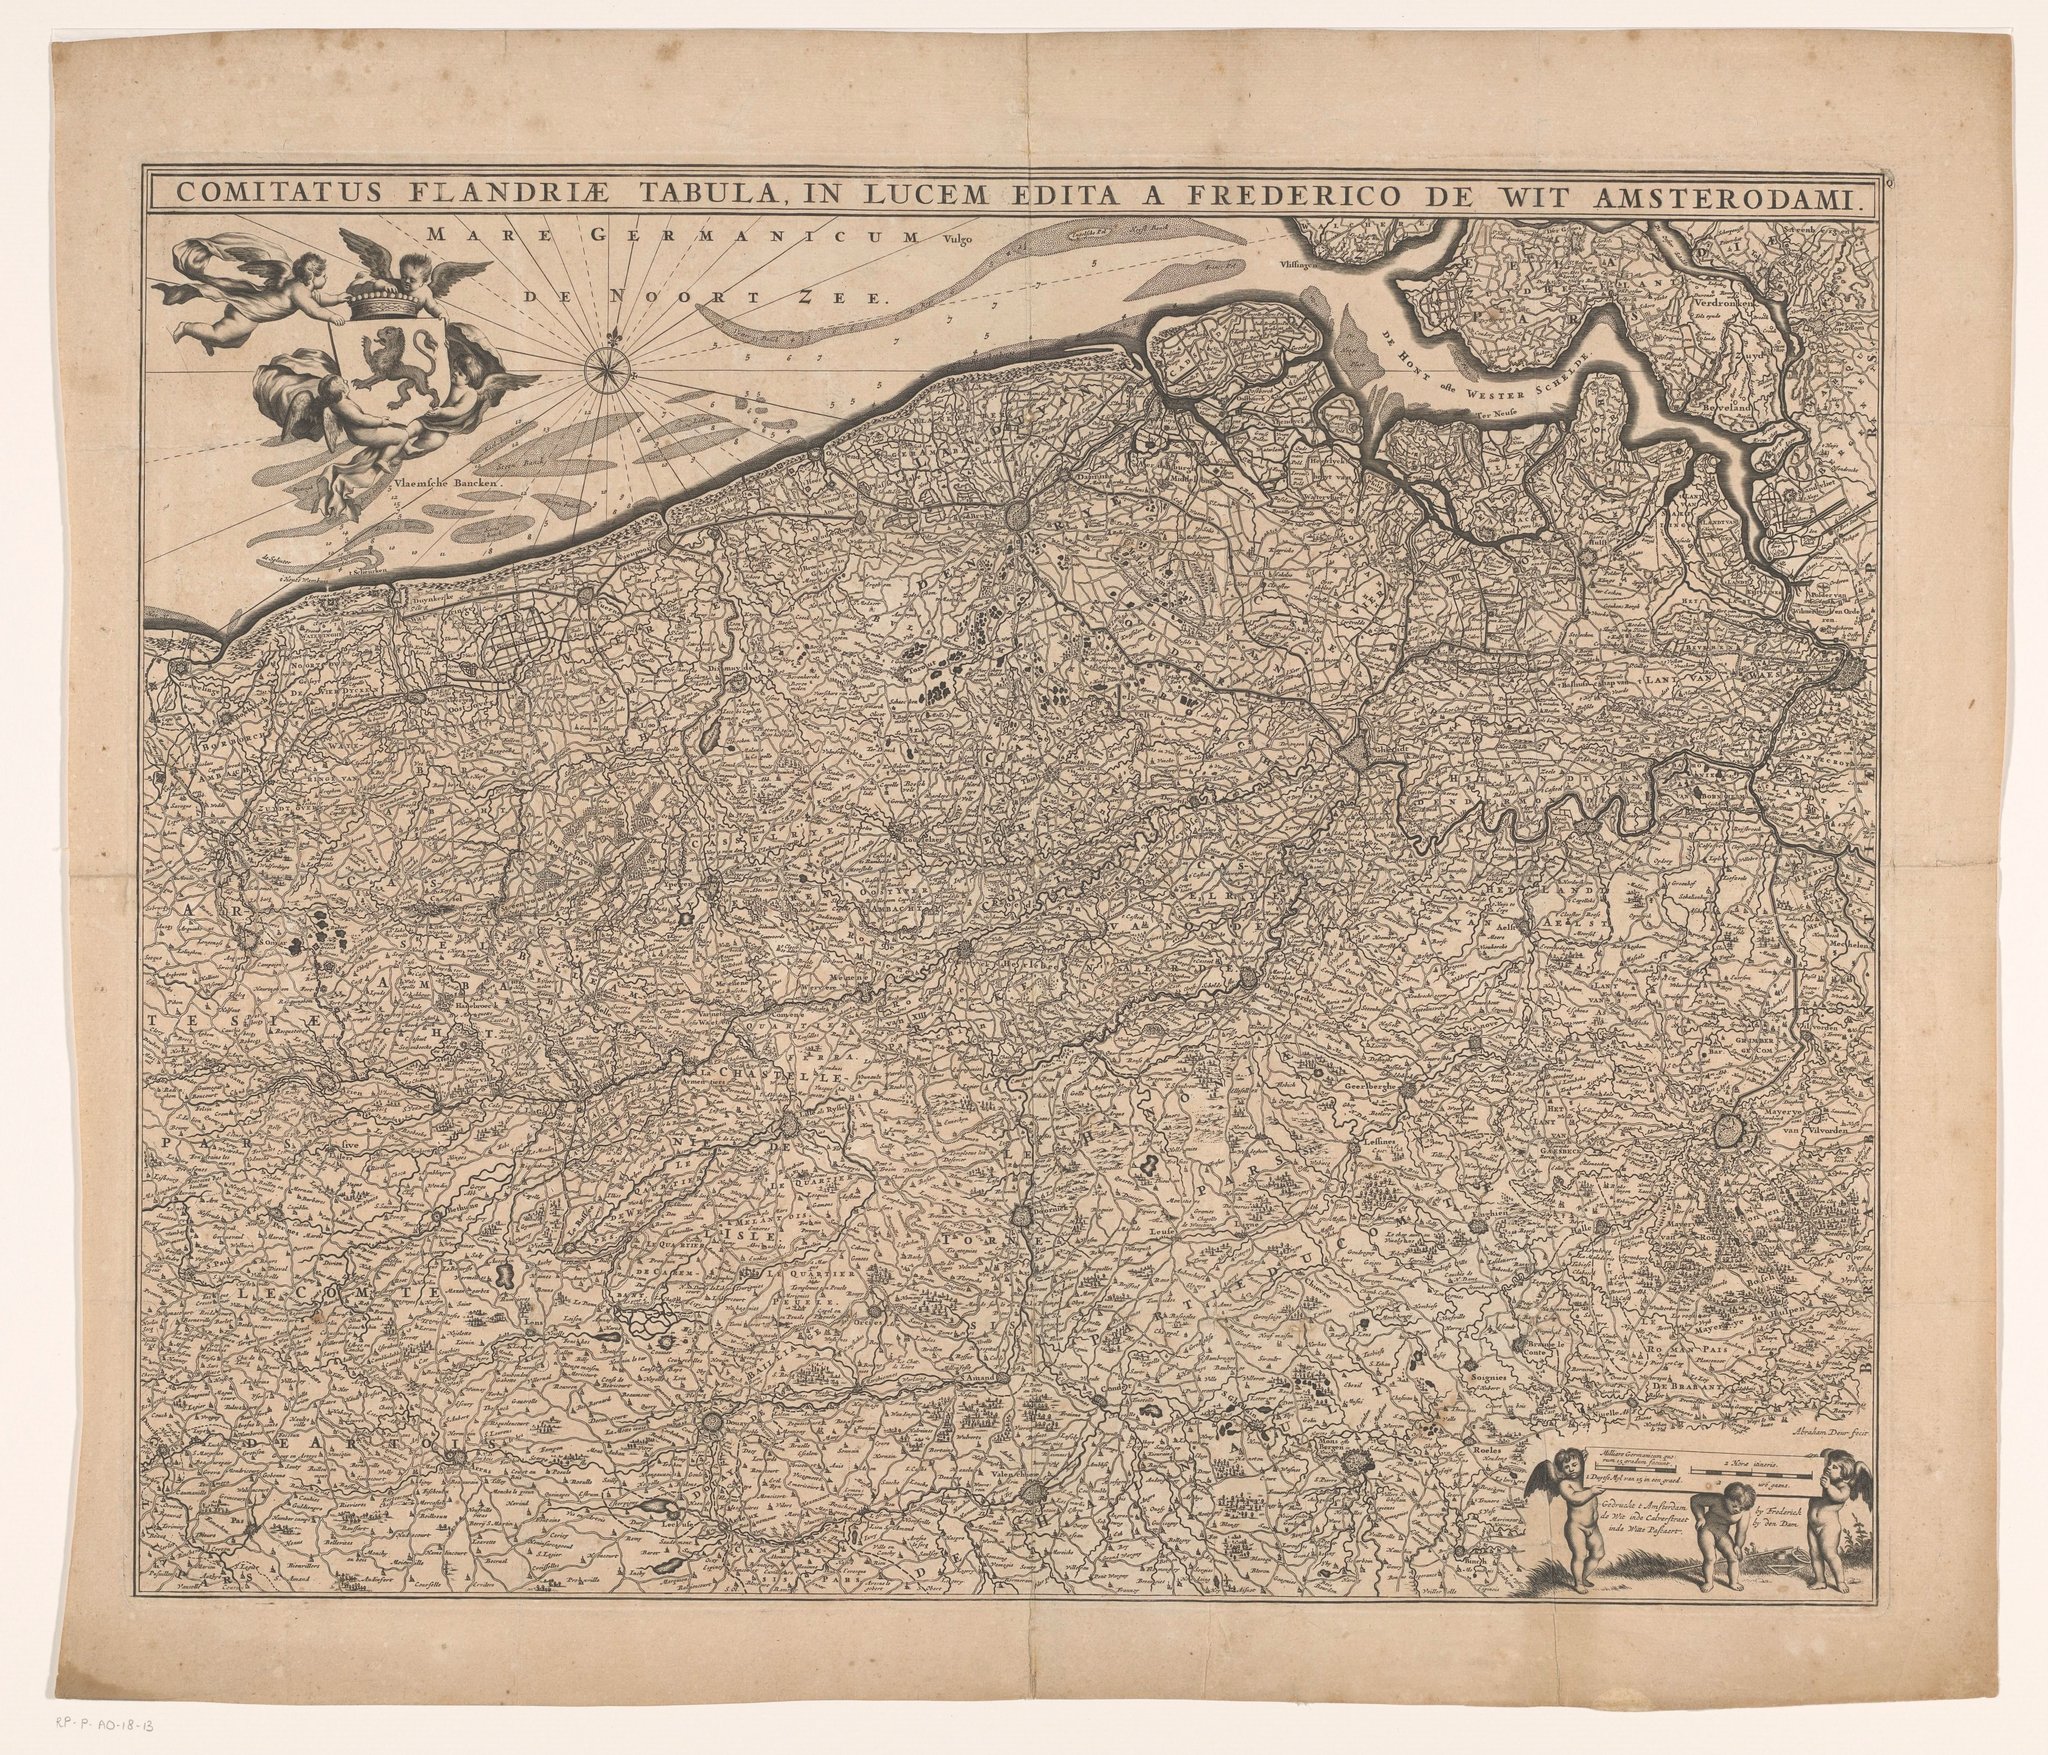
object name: print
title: Kaart van het graafschap Vlaanderen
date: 1666-1667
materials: paper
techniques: engraving, etching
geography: amsterdam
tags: maps of separate countries or regions, coat of arms (as symbol of the state, etc.) (+ province; provincial)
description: Kaart van het graafschap Vlaanderen. In een balk boven de kaart de titel. Linksboven vier putti die het wapen van het graafschap Vlaanderen dragen. Rechtsonder twee schaalstokken: 1 Duytse Myl van 15 in een graad / 2 ure gaens. Rechtsboven gemerkt: Q.